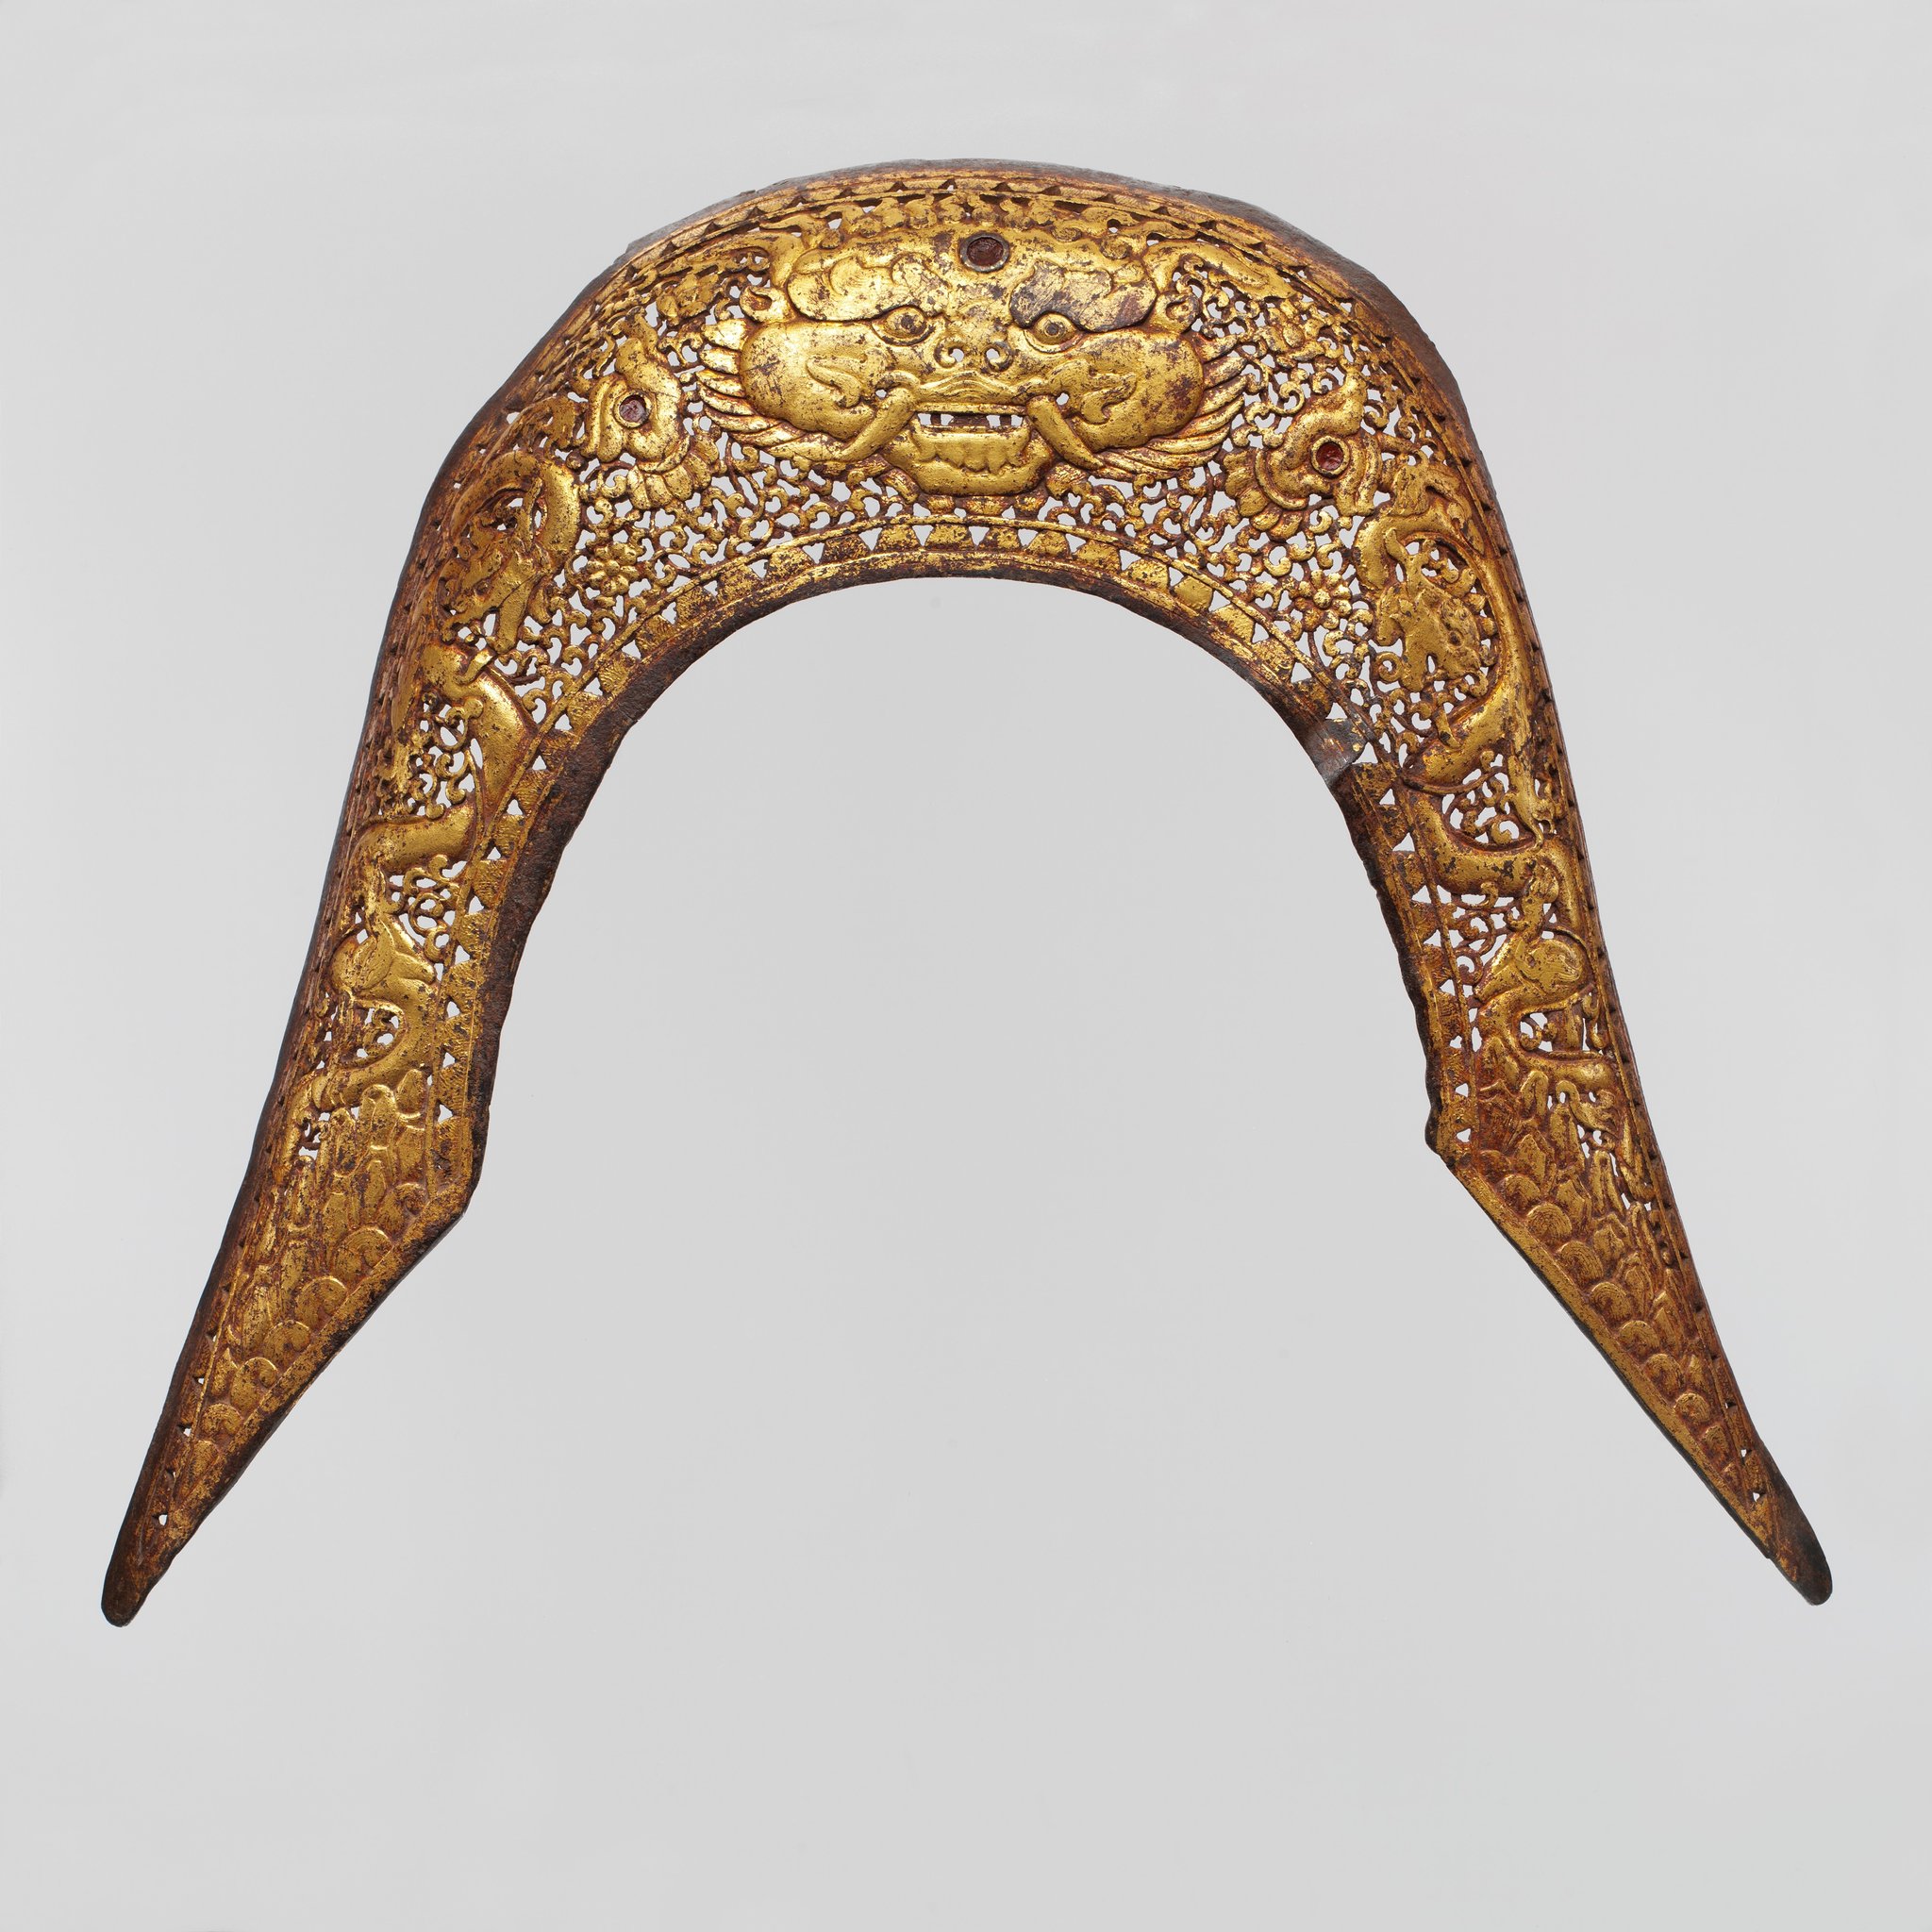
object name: pommel plate from a saddle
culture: tibetan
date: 1601-1900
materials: gold, iron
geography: tibet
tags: masks,dragons